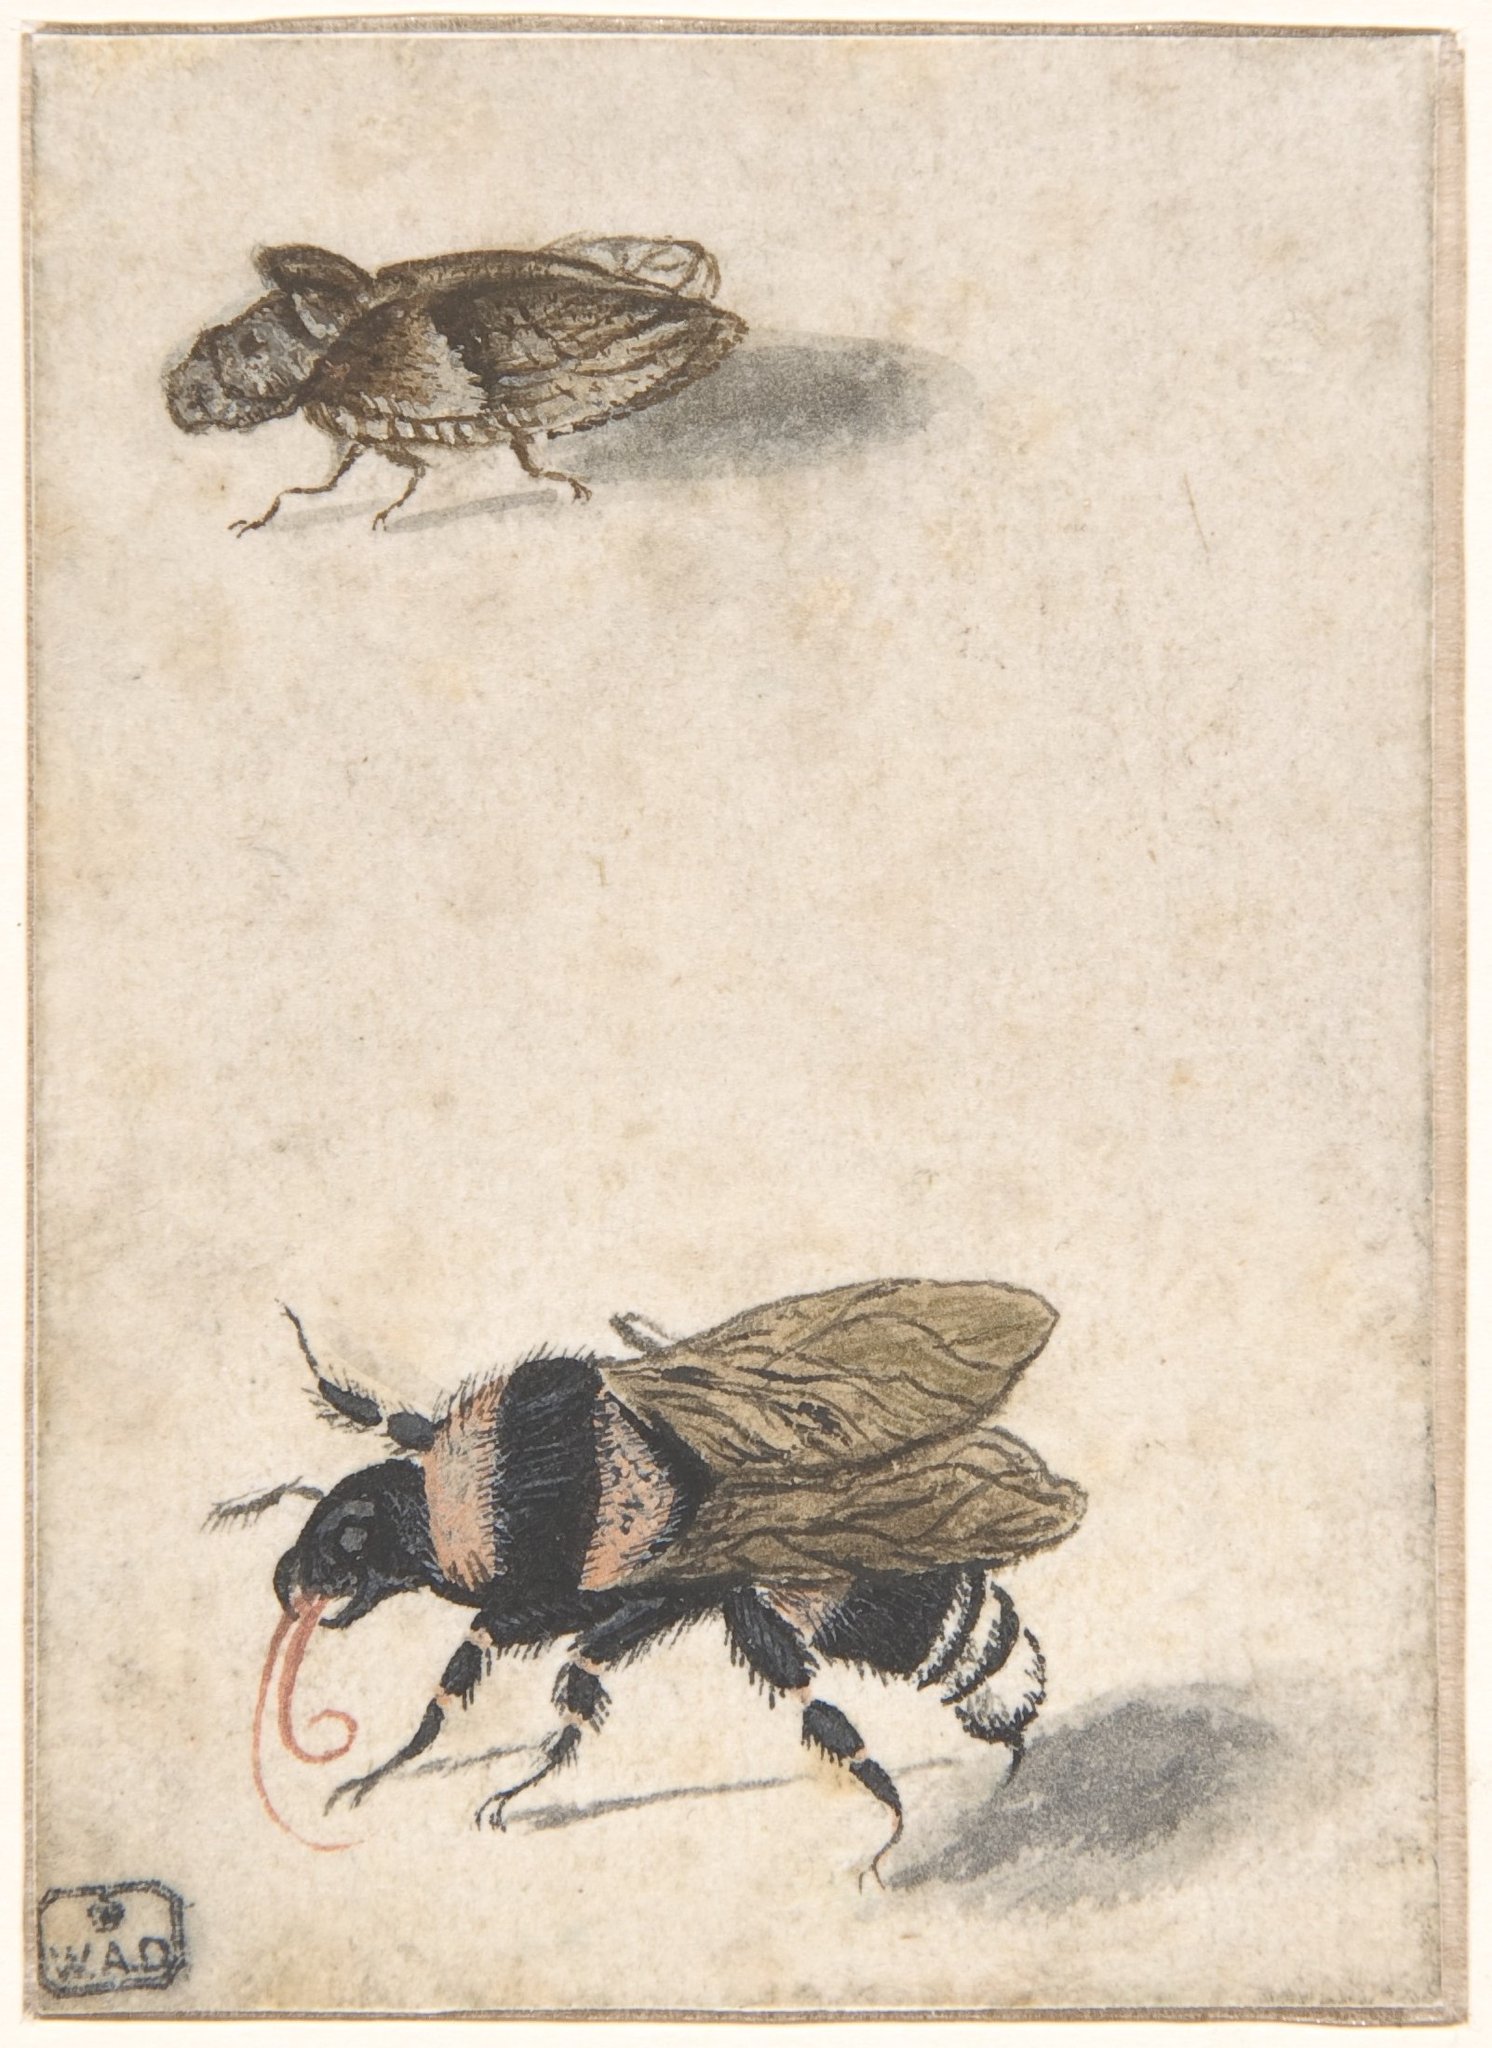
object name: drawing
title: A Bumble Bee and a Fulgoroid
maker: anonymous, dutch, 17th century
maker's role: artist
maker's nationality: dutch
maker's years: 1600-1700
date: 1601-1700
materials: gouache, ink, watercolor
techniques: pen, wash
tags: bees